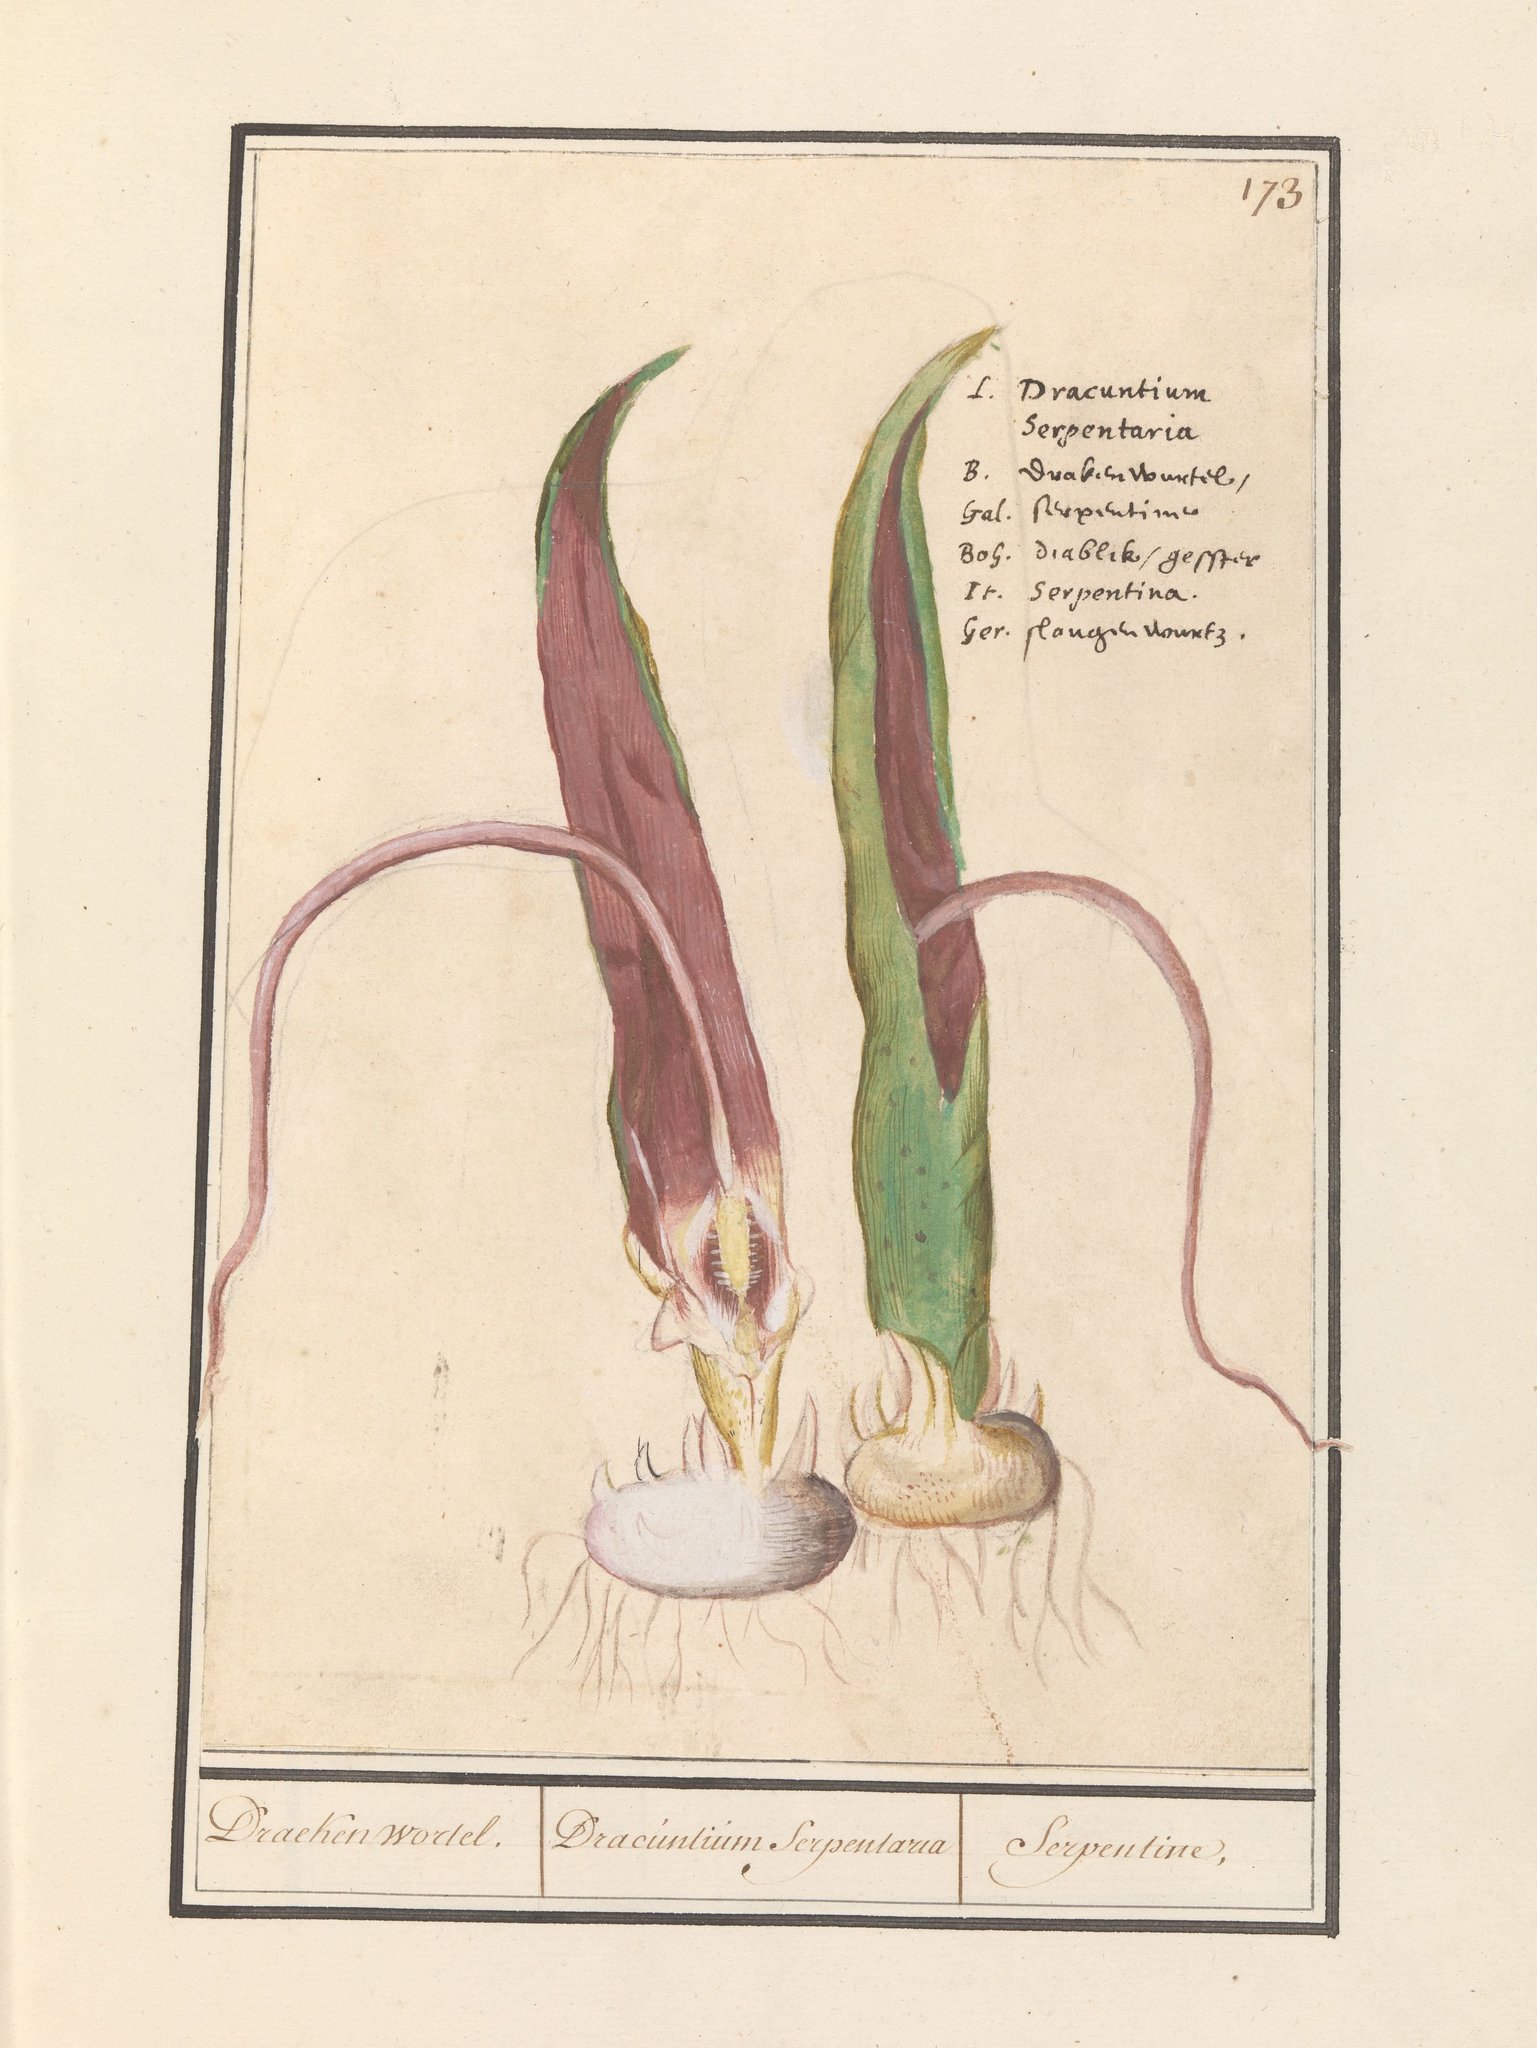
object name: drawing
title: Common Dracunculus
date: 1596-1610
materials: chalk, paint, ink, paper, watercolor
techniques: brush, pen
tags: flowers: dracunculus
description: Drakenwortel. Rechtsboven genummerd: 173. Rechtsboven de naam in zes talen. Onderdeel van het tweede album met tekeningen van bloemen en planten. Negende van twaalf albums met tekeningen van dieren, vogels en planten bekend rond 1600, gemaakt in opdracht van keizer Rudolf II. Met toelichting in Nederlands, Latijn en Frans.